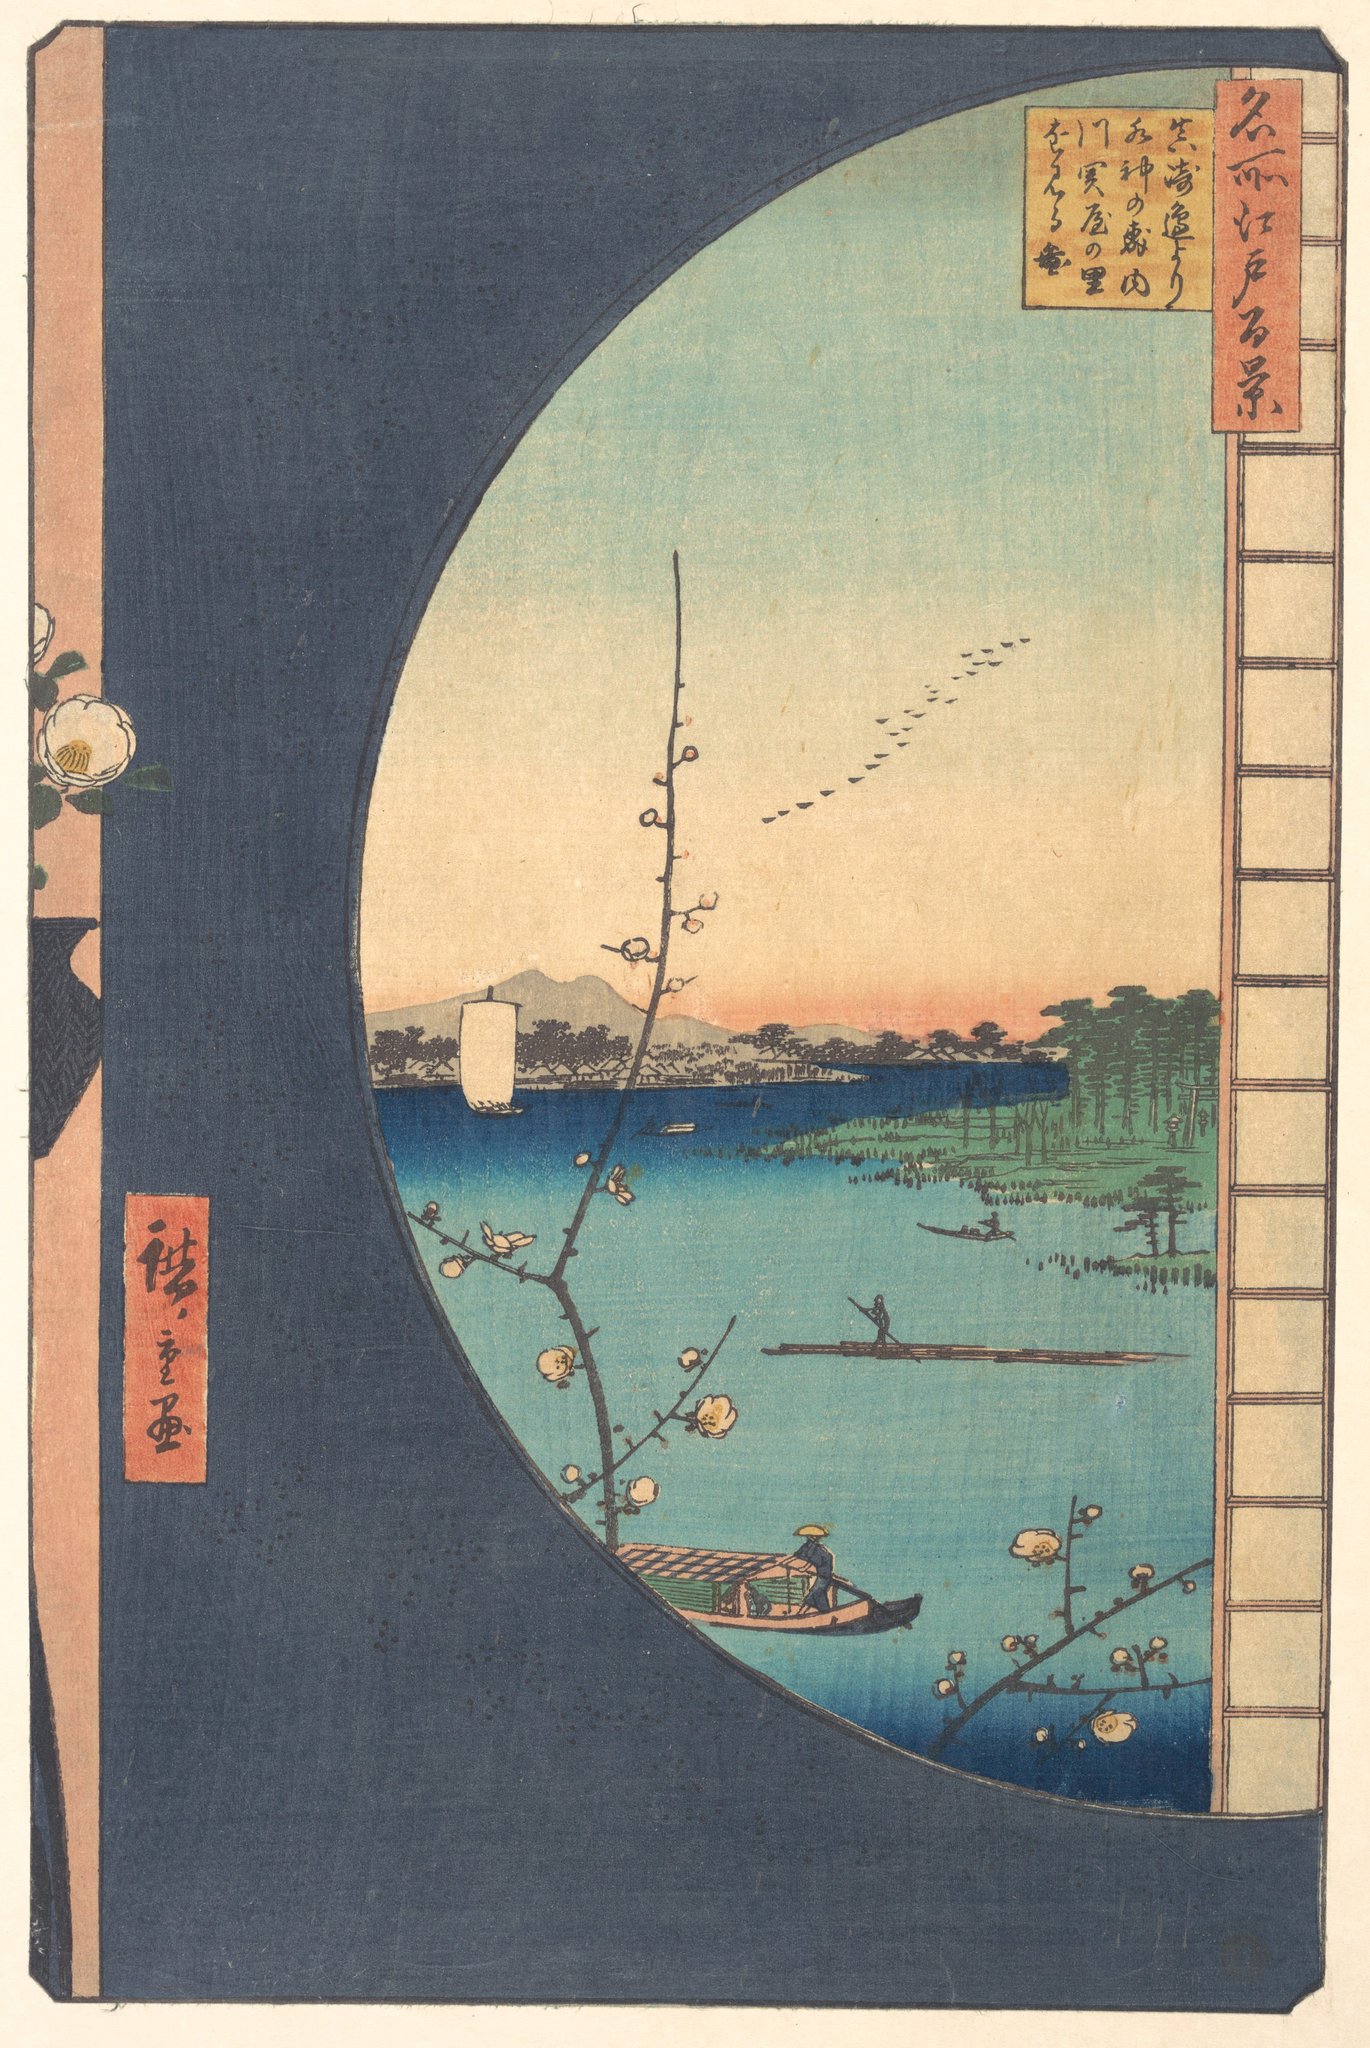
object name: print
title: Susaki Hen-yori Suijin no Mori, Uchikawa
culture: japanese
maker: utagawa hiroshige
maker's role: artist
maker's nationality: japanese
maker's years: 1797-1858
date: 1857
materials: ink, paper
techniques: woodblock print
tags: landscapes,boats